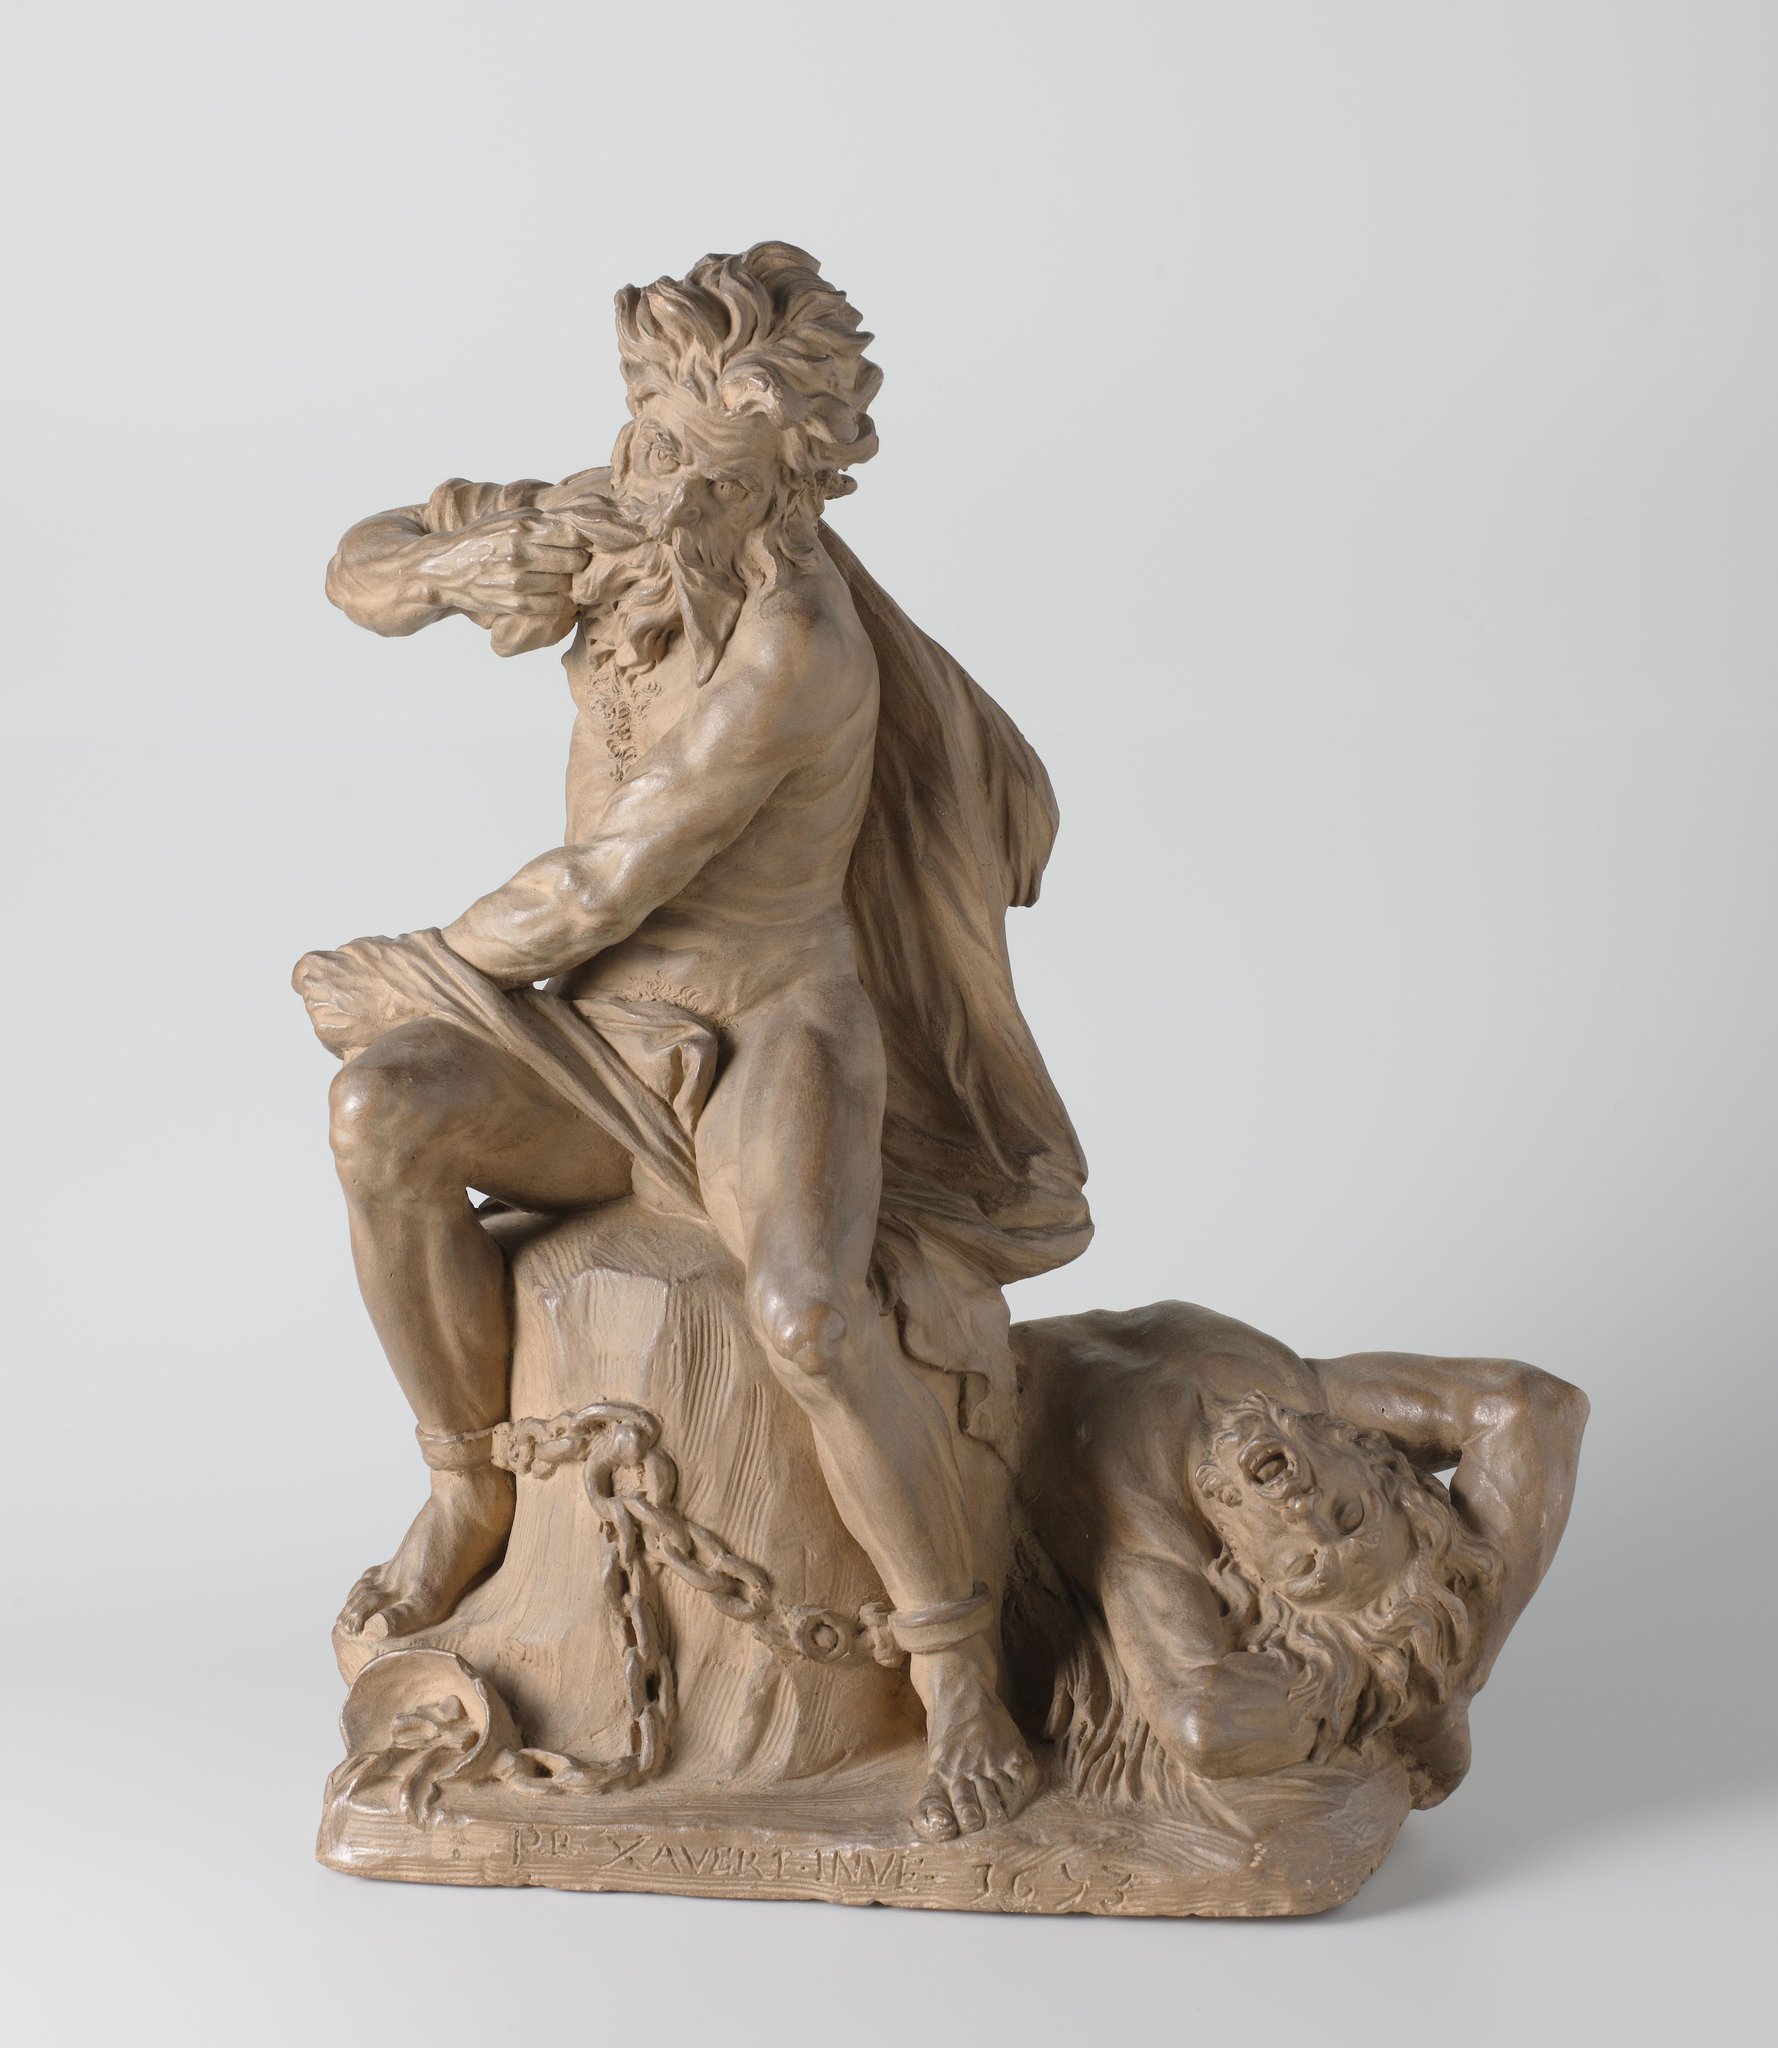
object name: sculpture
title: Two raving Madmen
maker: pieter xaveri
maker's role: sculptor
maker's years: 1647-1673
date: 1673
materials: terracotta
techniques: modeling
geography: leiden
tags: emotional illness, derangement, madness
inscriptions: signature and date, along the plinth’s front edge, incised in the wet clay: ‘P∙R∙ XAVERI∙ INVE 1673’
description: Between 1670 and 1673, the year of his death, the Antwerp sculptor Pieter Xaveri lived in Leiden, where he made small sculptures modelled in terracotta. Many of them are anecdotal. The meaning of this unusual depiction of two fettered men in a frenzy is unknown.